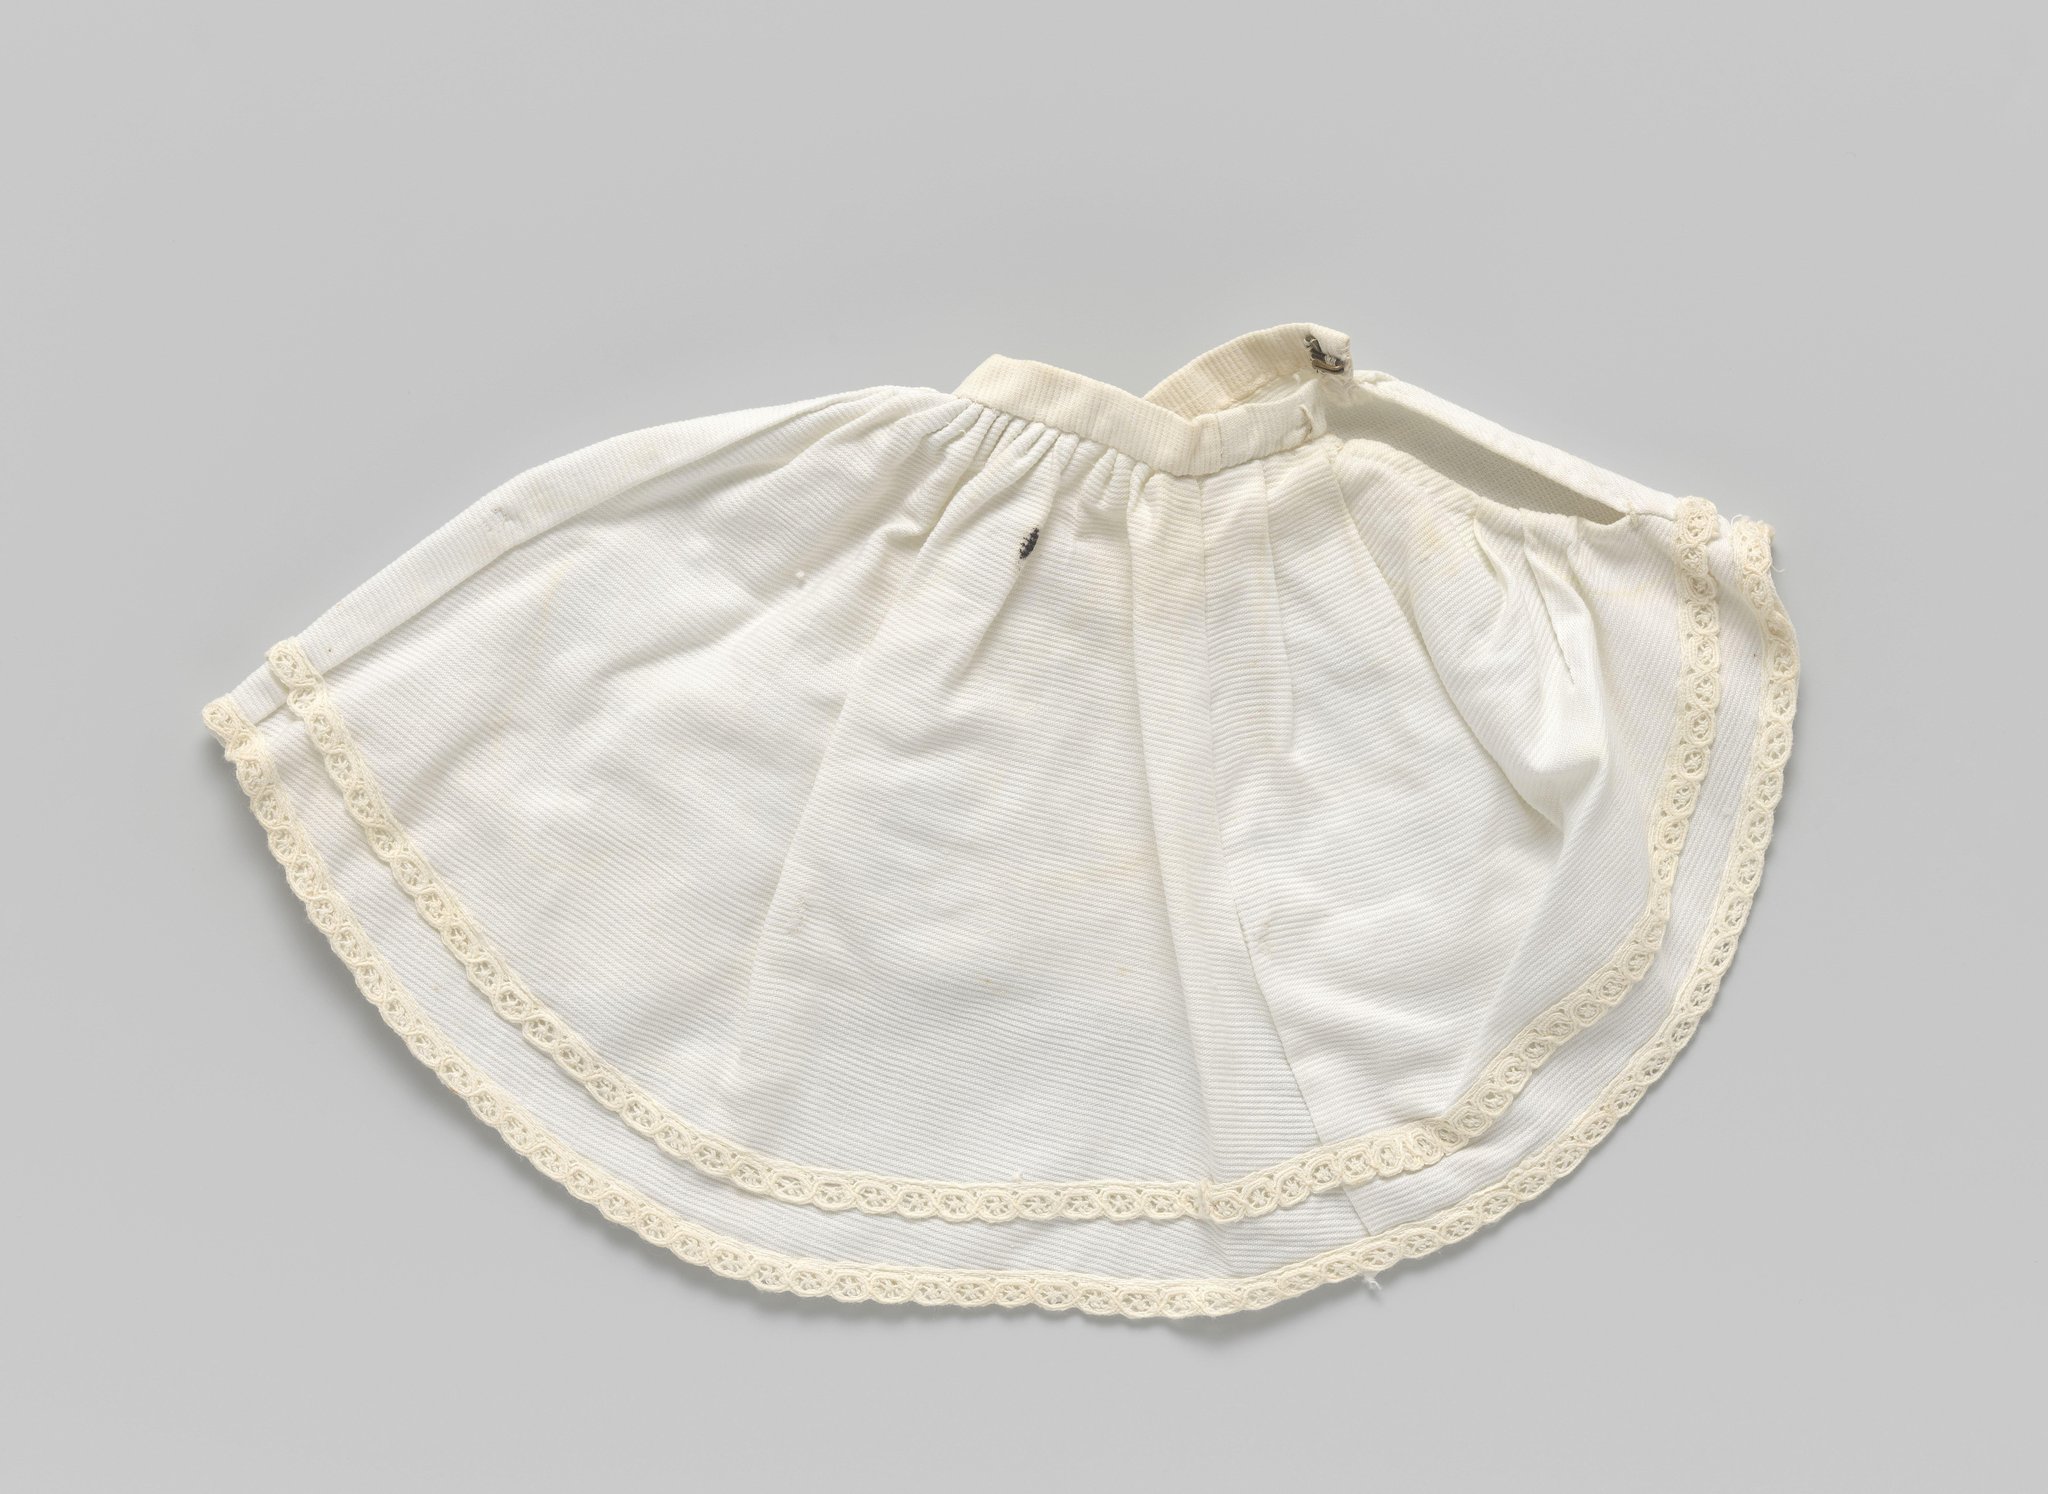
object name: doll's clothing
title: Onderrok van wit katoen afgezet aan de onderzijde met twee stroken kant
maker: Anonymous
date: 1850-1920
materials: cotton, metal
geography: europe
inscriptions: number: ‘RBK 15445’